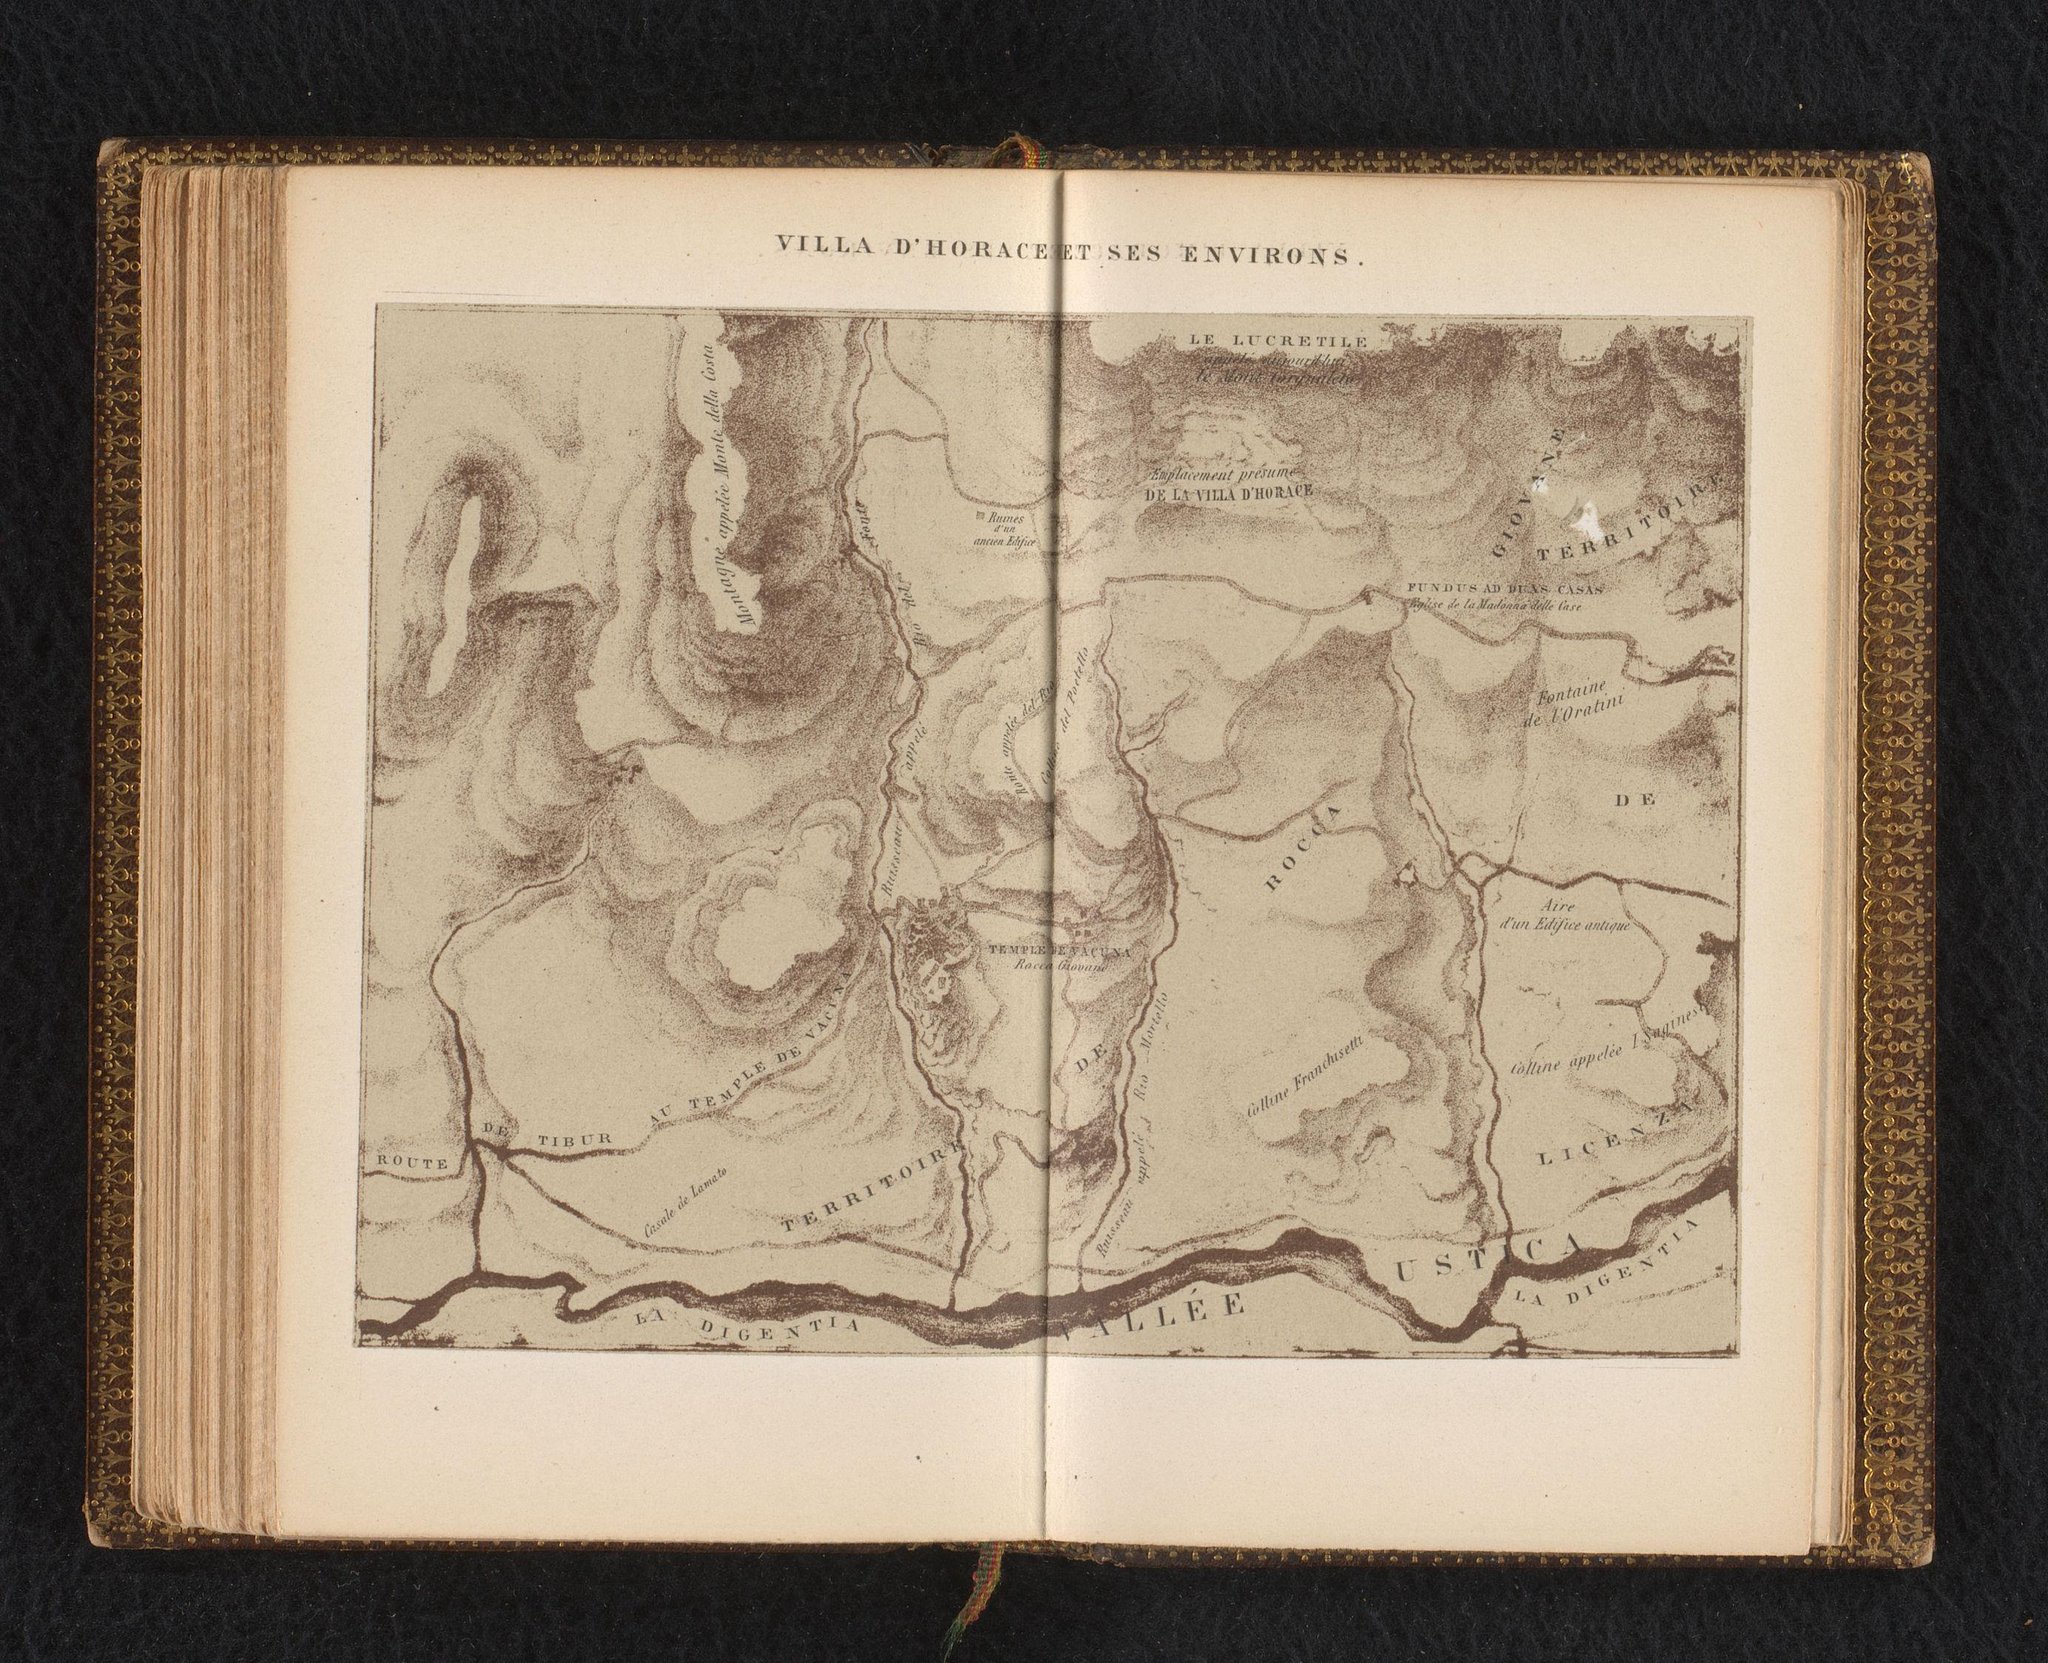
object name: print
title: Villa d'Horace et ses environs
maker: Anonymous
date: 1851-1855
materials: paper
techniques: lithograph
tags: maps of separate countries or regions